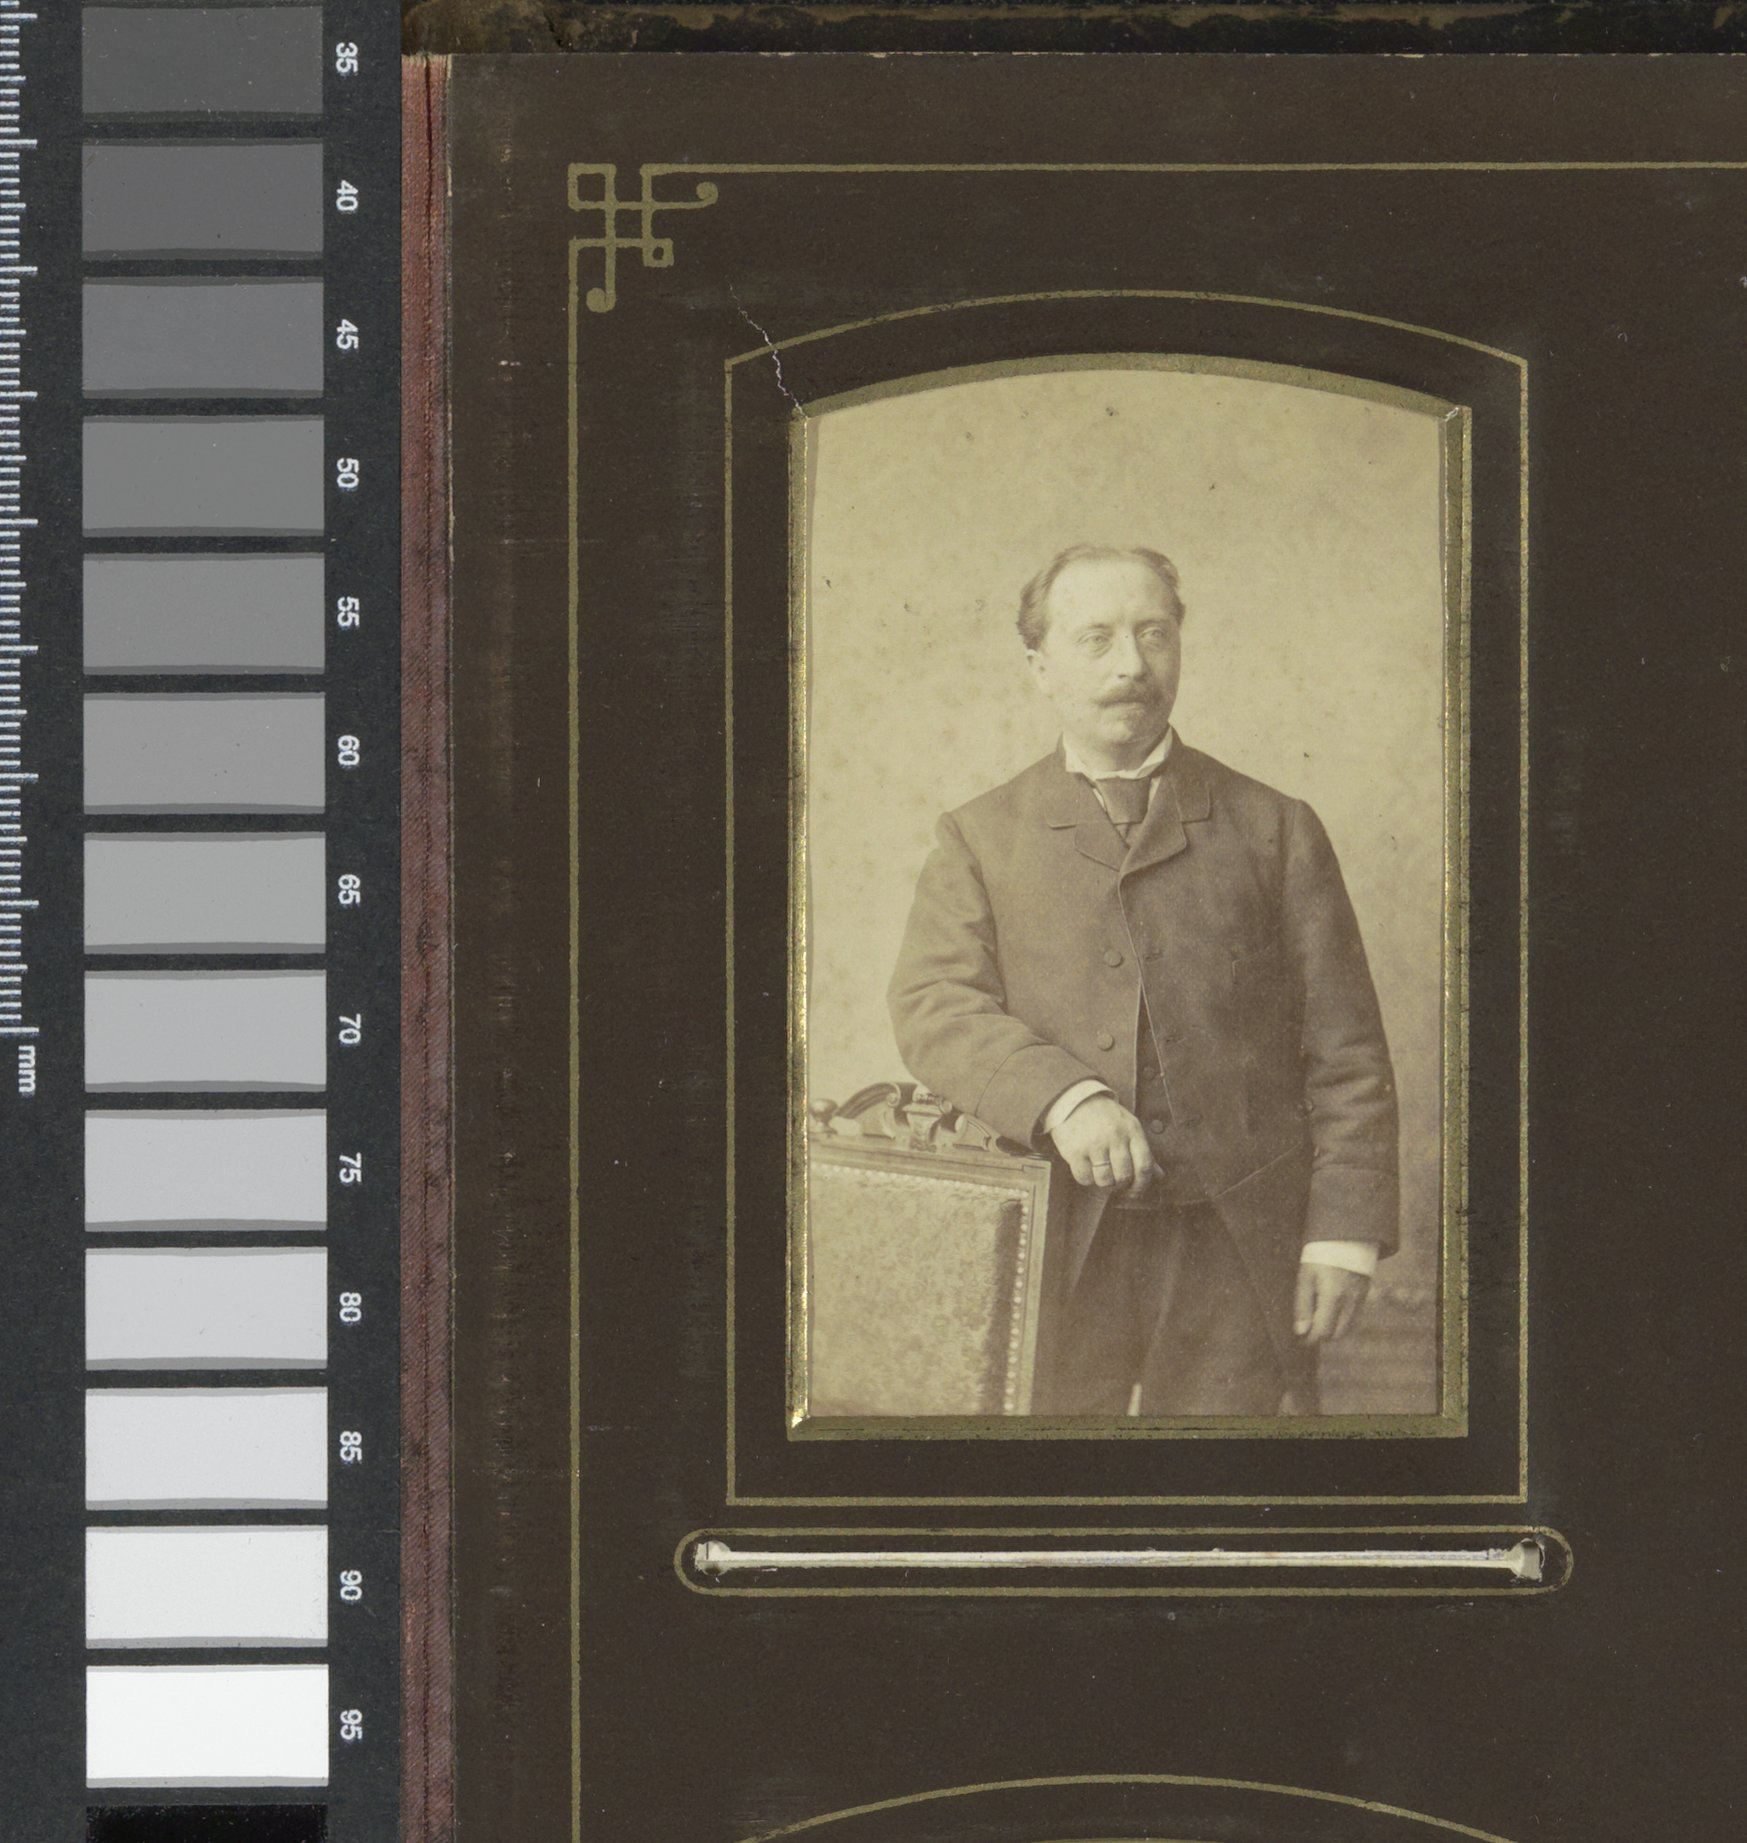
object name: carte de visite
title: Portret van een man, staand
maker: albert greiner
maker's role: fotograaf, fotostudio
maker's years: 1833-1890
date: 1861-1874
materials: cardboard, paper, photographic support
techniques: albumen print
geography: amsterdam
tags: studio requisites ~ photographer, adult man, historical persons not known by name, amsterdam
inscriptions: address: ‘Amsterdam Nieuwendijk L. 89.’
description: Onderdeel van Fotoalbum van de families Matthes, Doorman en Van Thiel.